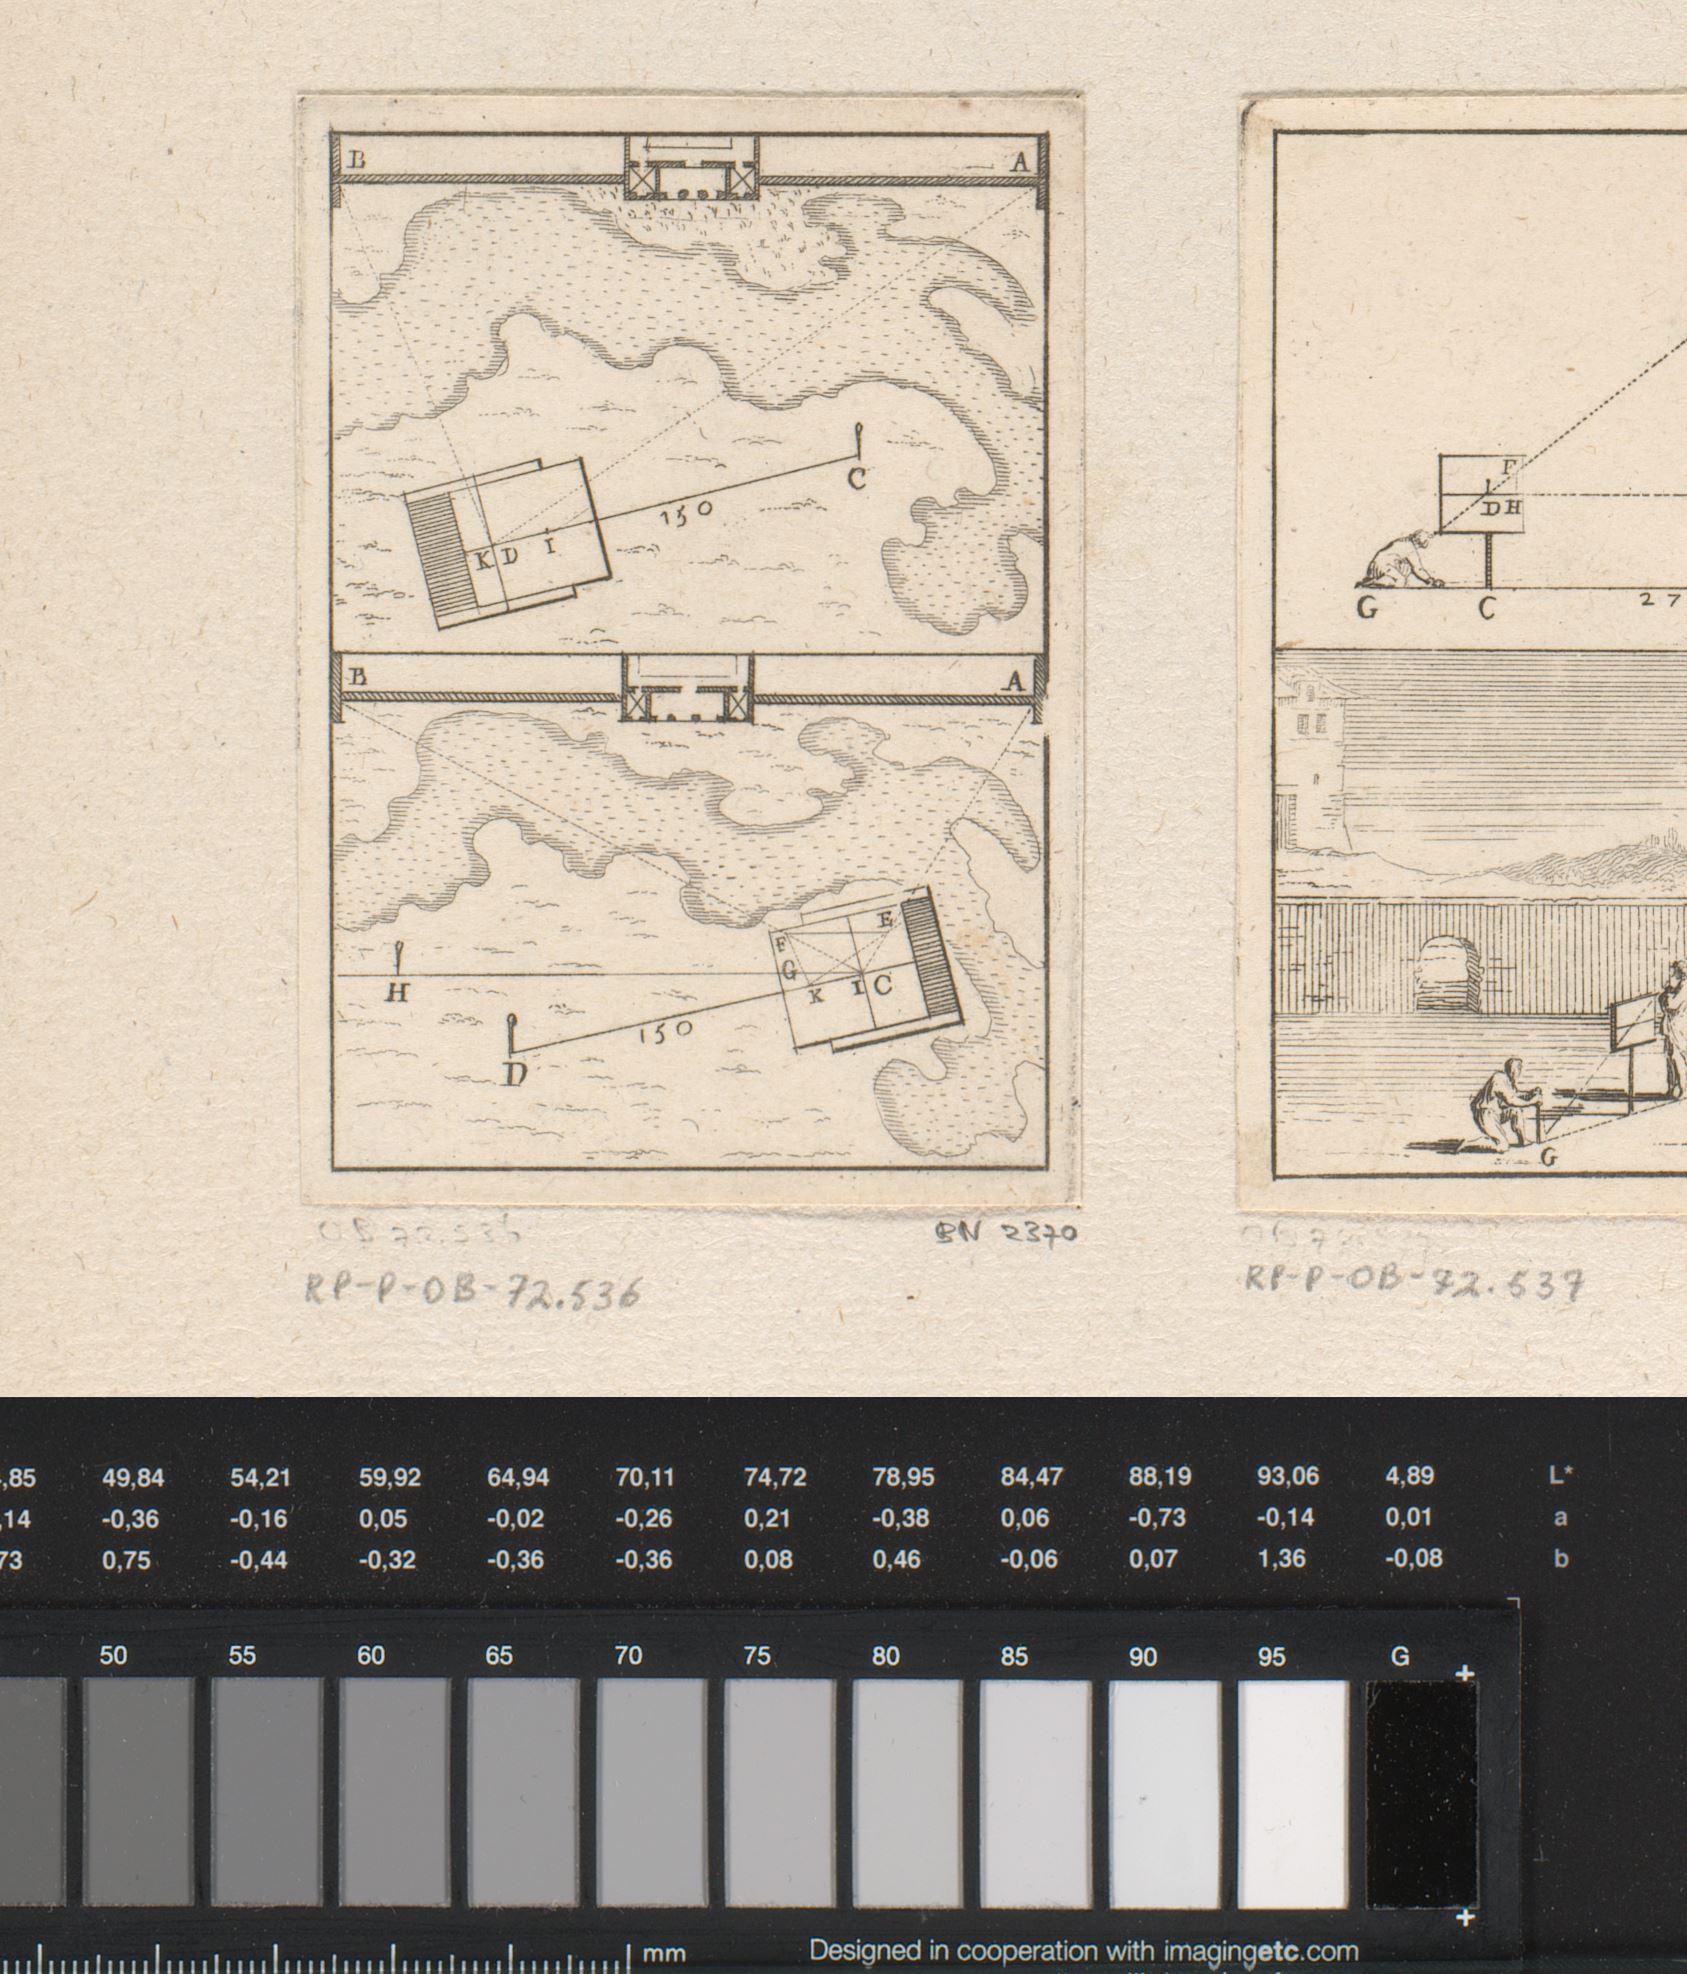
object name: print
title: Vanuit een gegeven punt een parallel trekken met de muur AB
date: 1669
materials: paper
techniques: etching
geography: france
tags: planimetry, geometry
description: Prent toegevoegd aan: Pratique de la géometrie, sur le papier et sur le terrain. Avec un nouvel ordre et une méthode particulière. Parijs: Thomas Jolly, 1669.